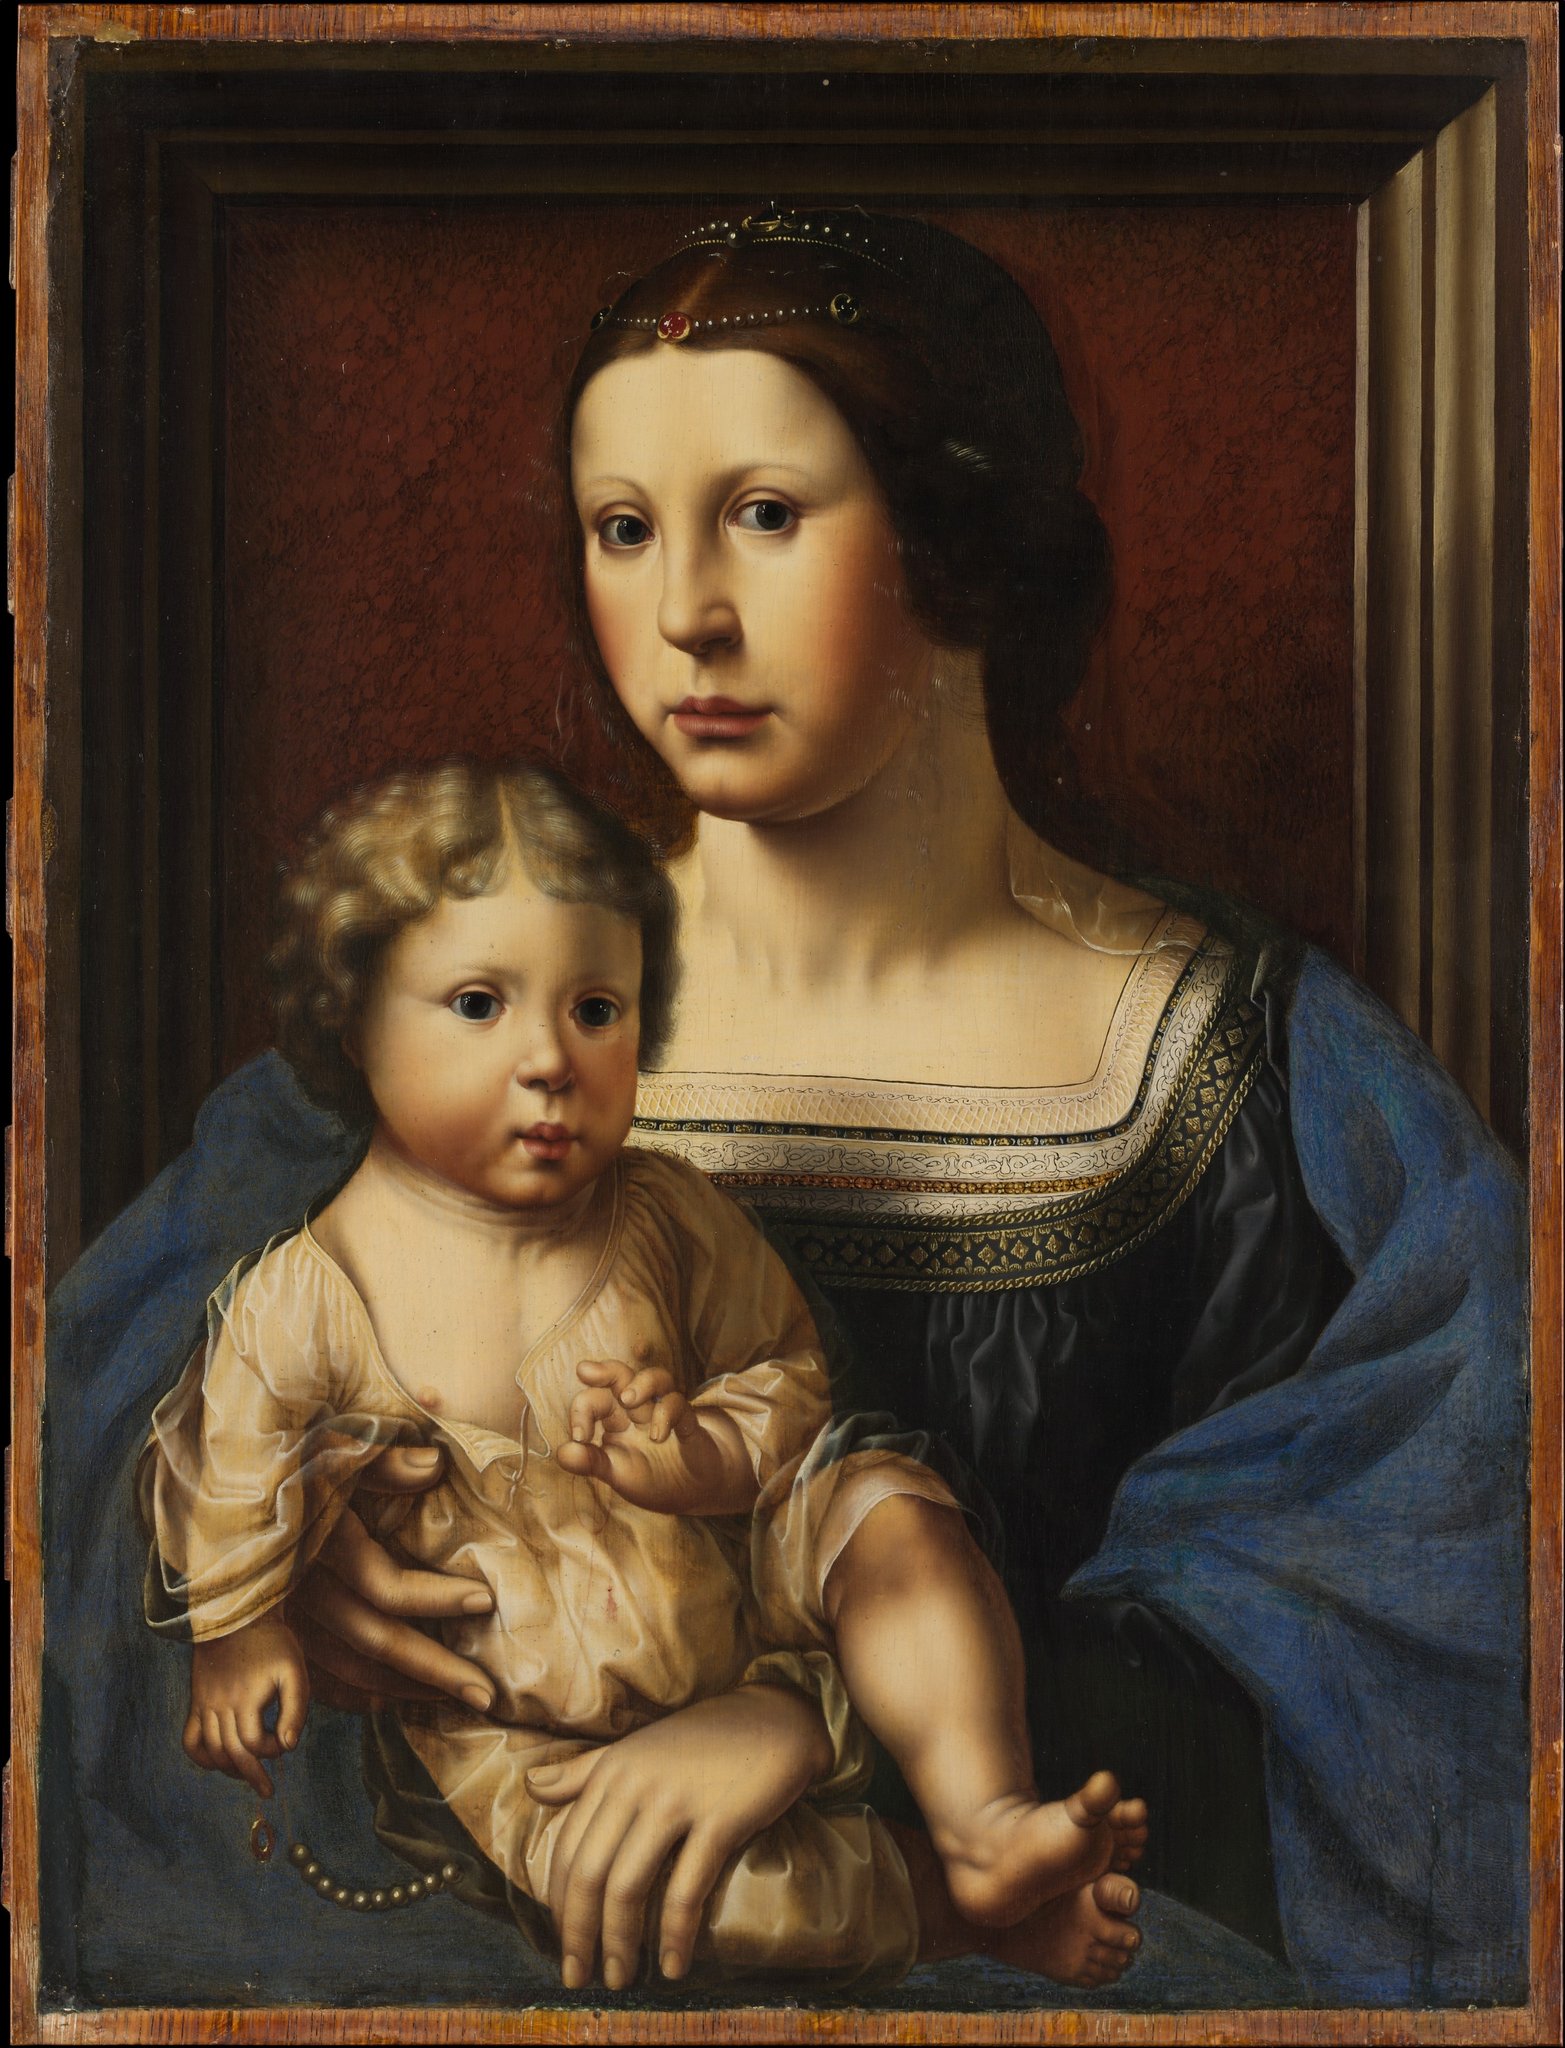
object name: painting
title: Anna van Bergen (1492–1541) and Her Son Hendrik (born 1519) as the Virgin and Child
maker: jan gossart (called mabuse)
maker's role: artist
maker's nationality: netherlandish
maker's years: 1478-1532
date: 1517-1527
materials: oil, wood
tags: madonna and child